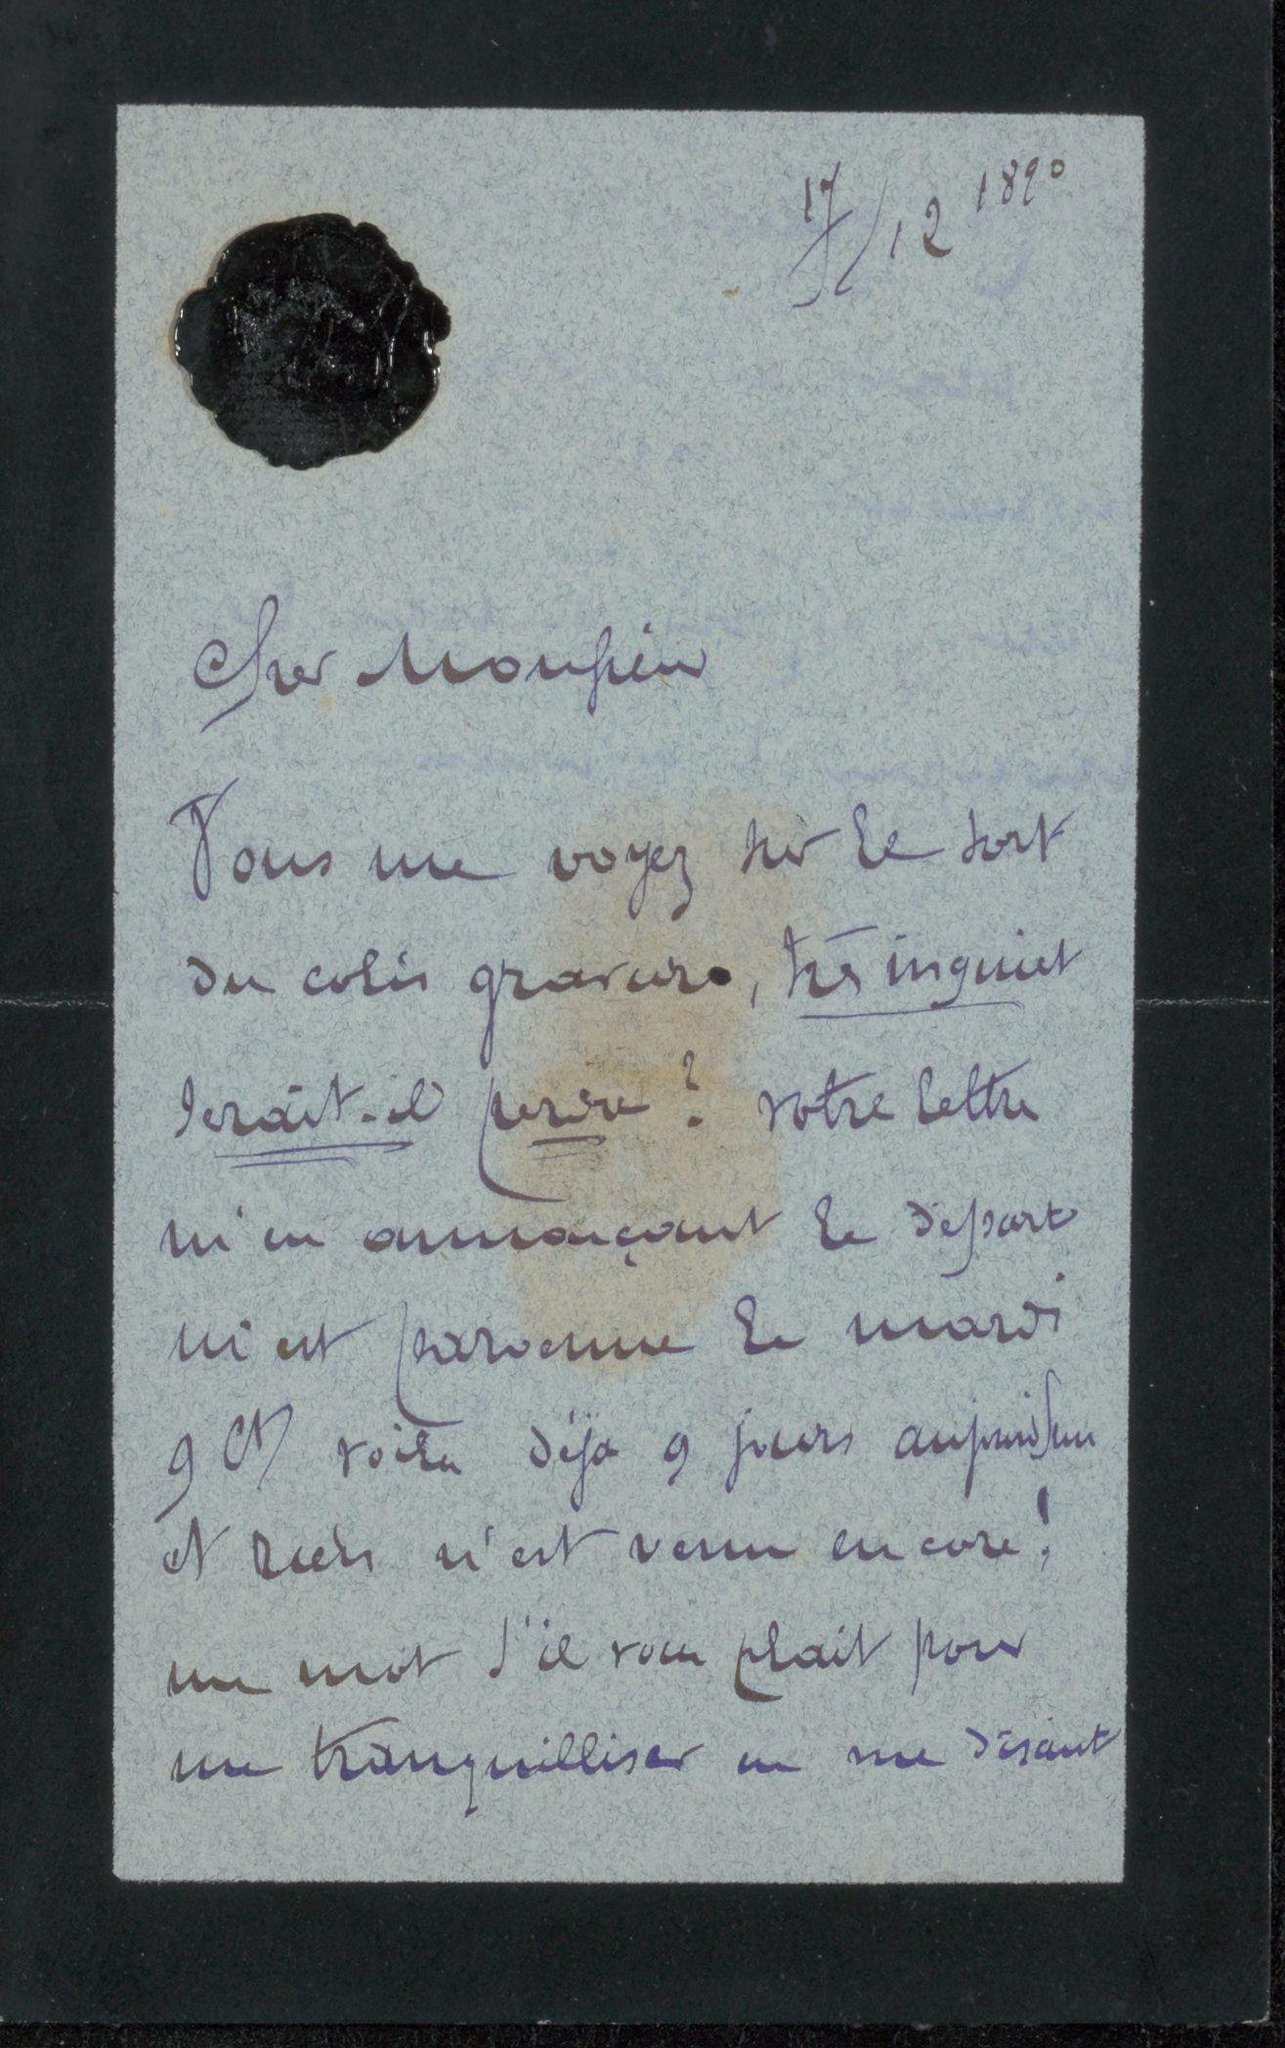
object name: letter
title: Brief aan Philip Zilcken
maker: gustave bourcard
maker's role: verzamelaar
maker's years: 1846-1925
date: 1890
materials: ink, paper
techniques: pen, writing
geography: nantes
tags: painter, draughtsman, philip zilcken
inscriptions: collector's mark: ‘RPK’, seal